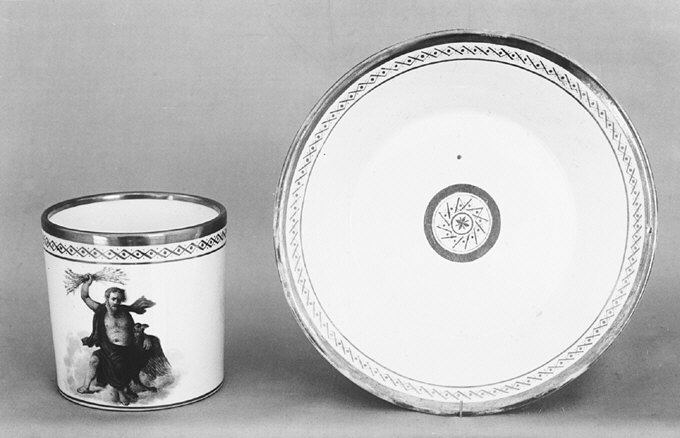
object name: cup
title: Cup (part of a coffee service)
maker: nymphenburg porcelain manufactory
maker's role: manufactory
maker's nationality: german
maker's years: 1747-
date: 1801-1833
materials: hard paste porcelain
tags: men